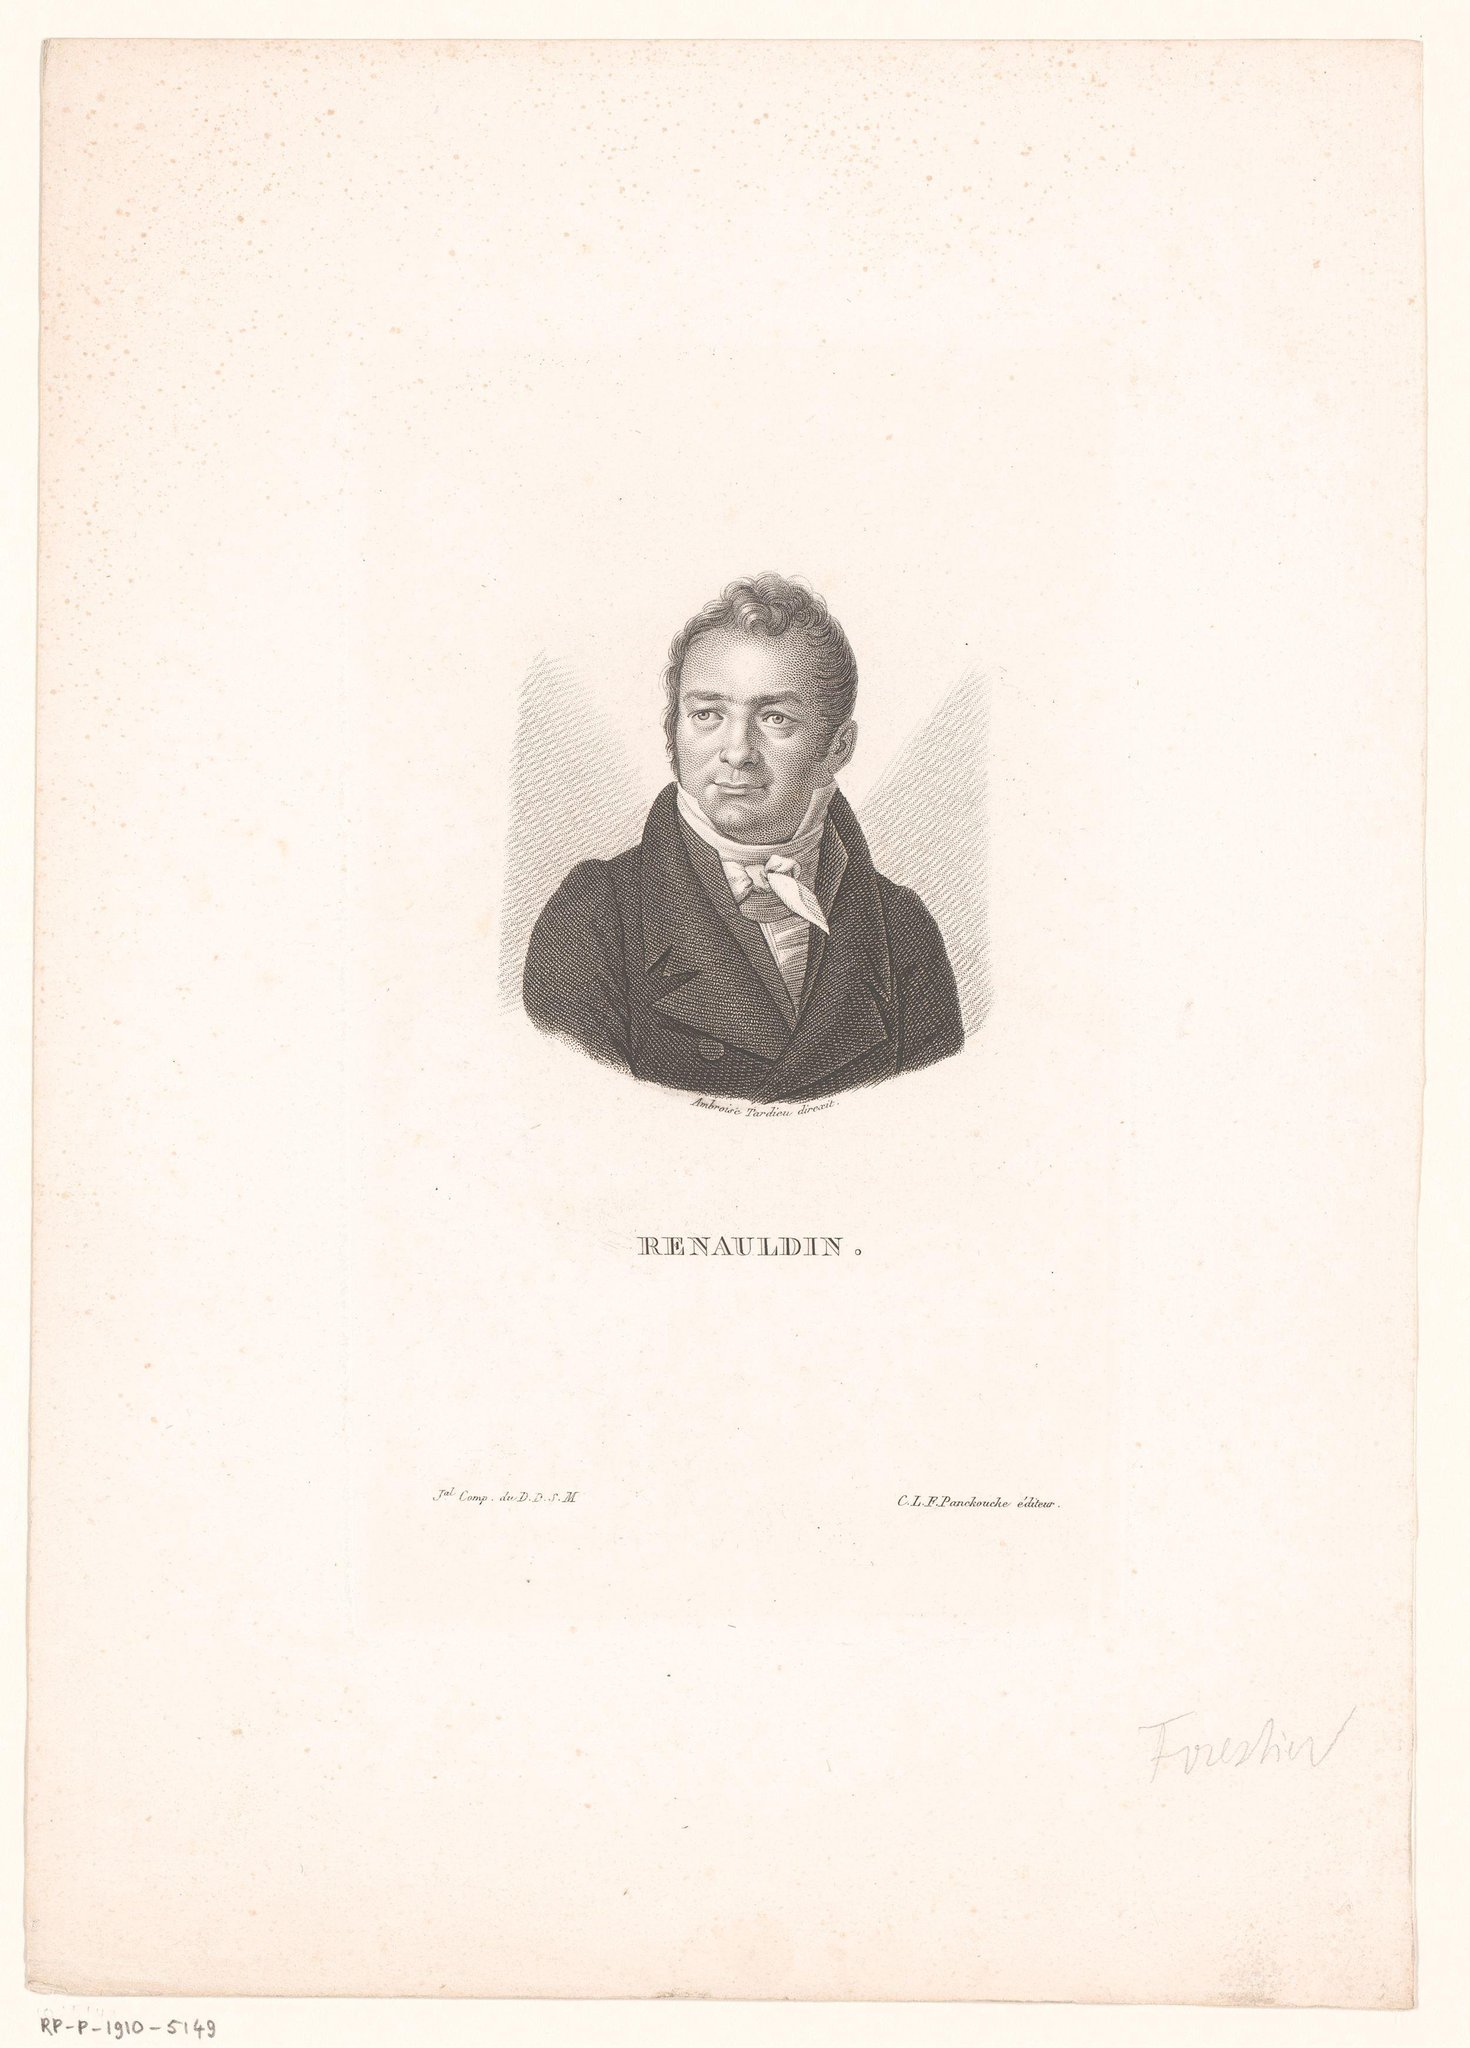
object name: book illustration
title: Portret van Léopold Joseph Renauldin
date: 1818-1832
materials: paper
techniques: engraving, roulette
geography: france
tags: historical persons, physician, doctor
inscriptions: collector's mark: Lugt 2228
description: Prent uit: Journal complémentaire du Dictionnaire des sciences médicales. Parijs: Panckoucke, Charles Louis Fleury, 1818-1832.